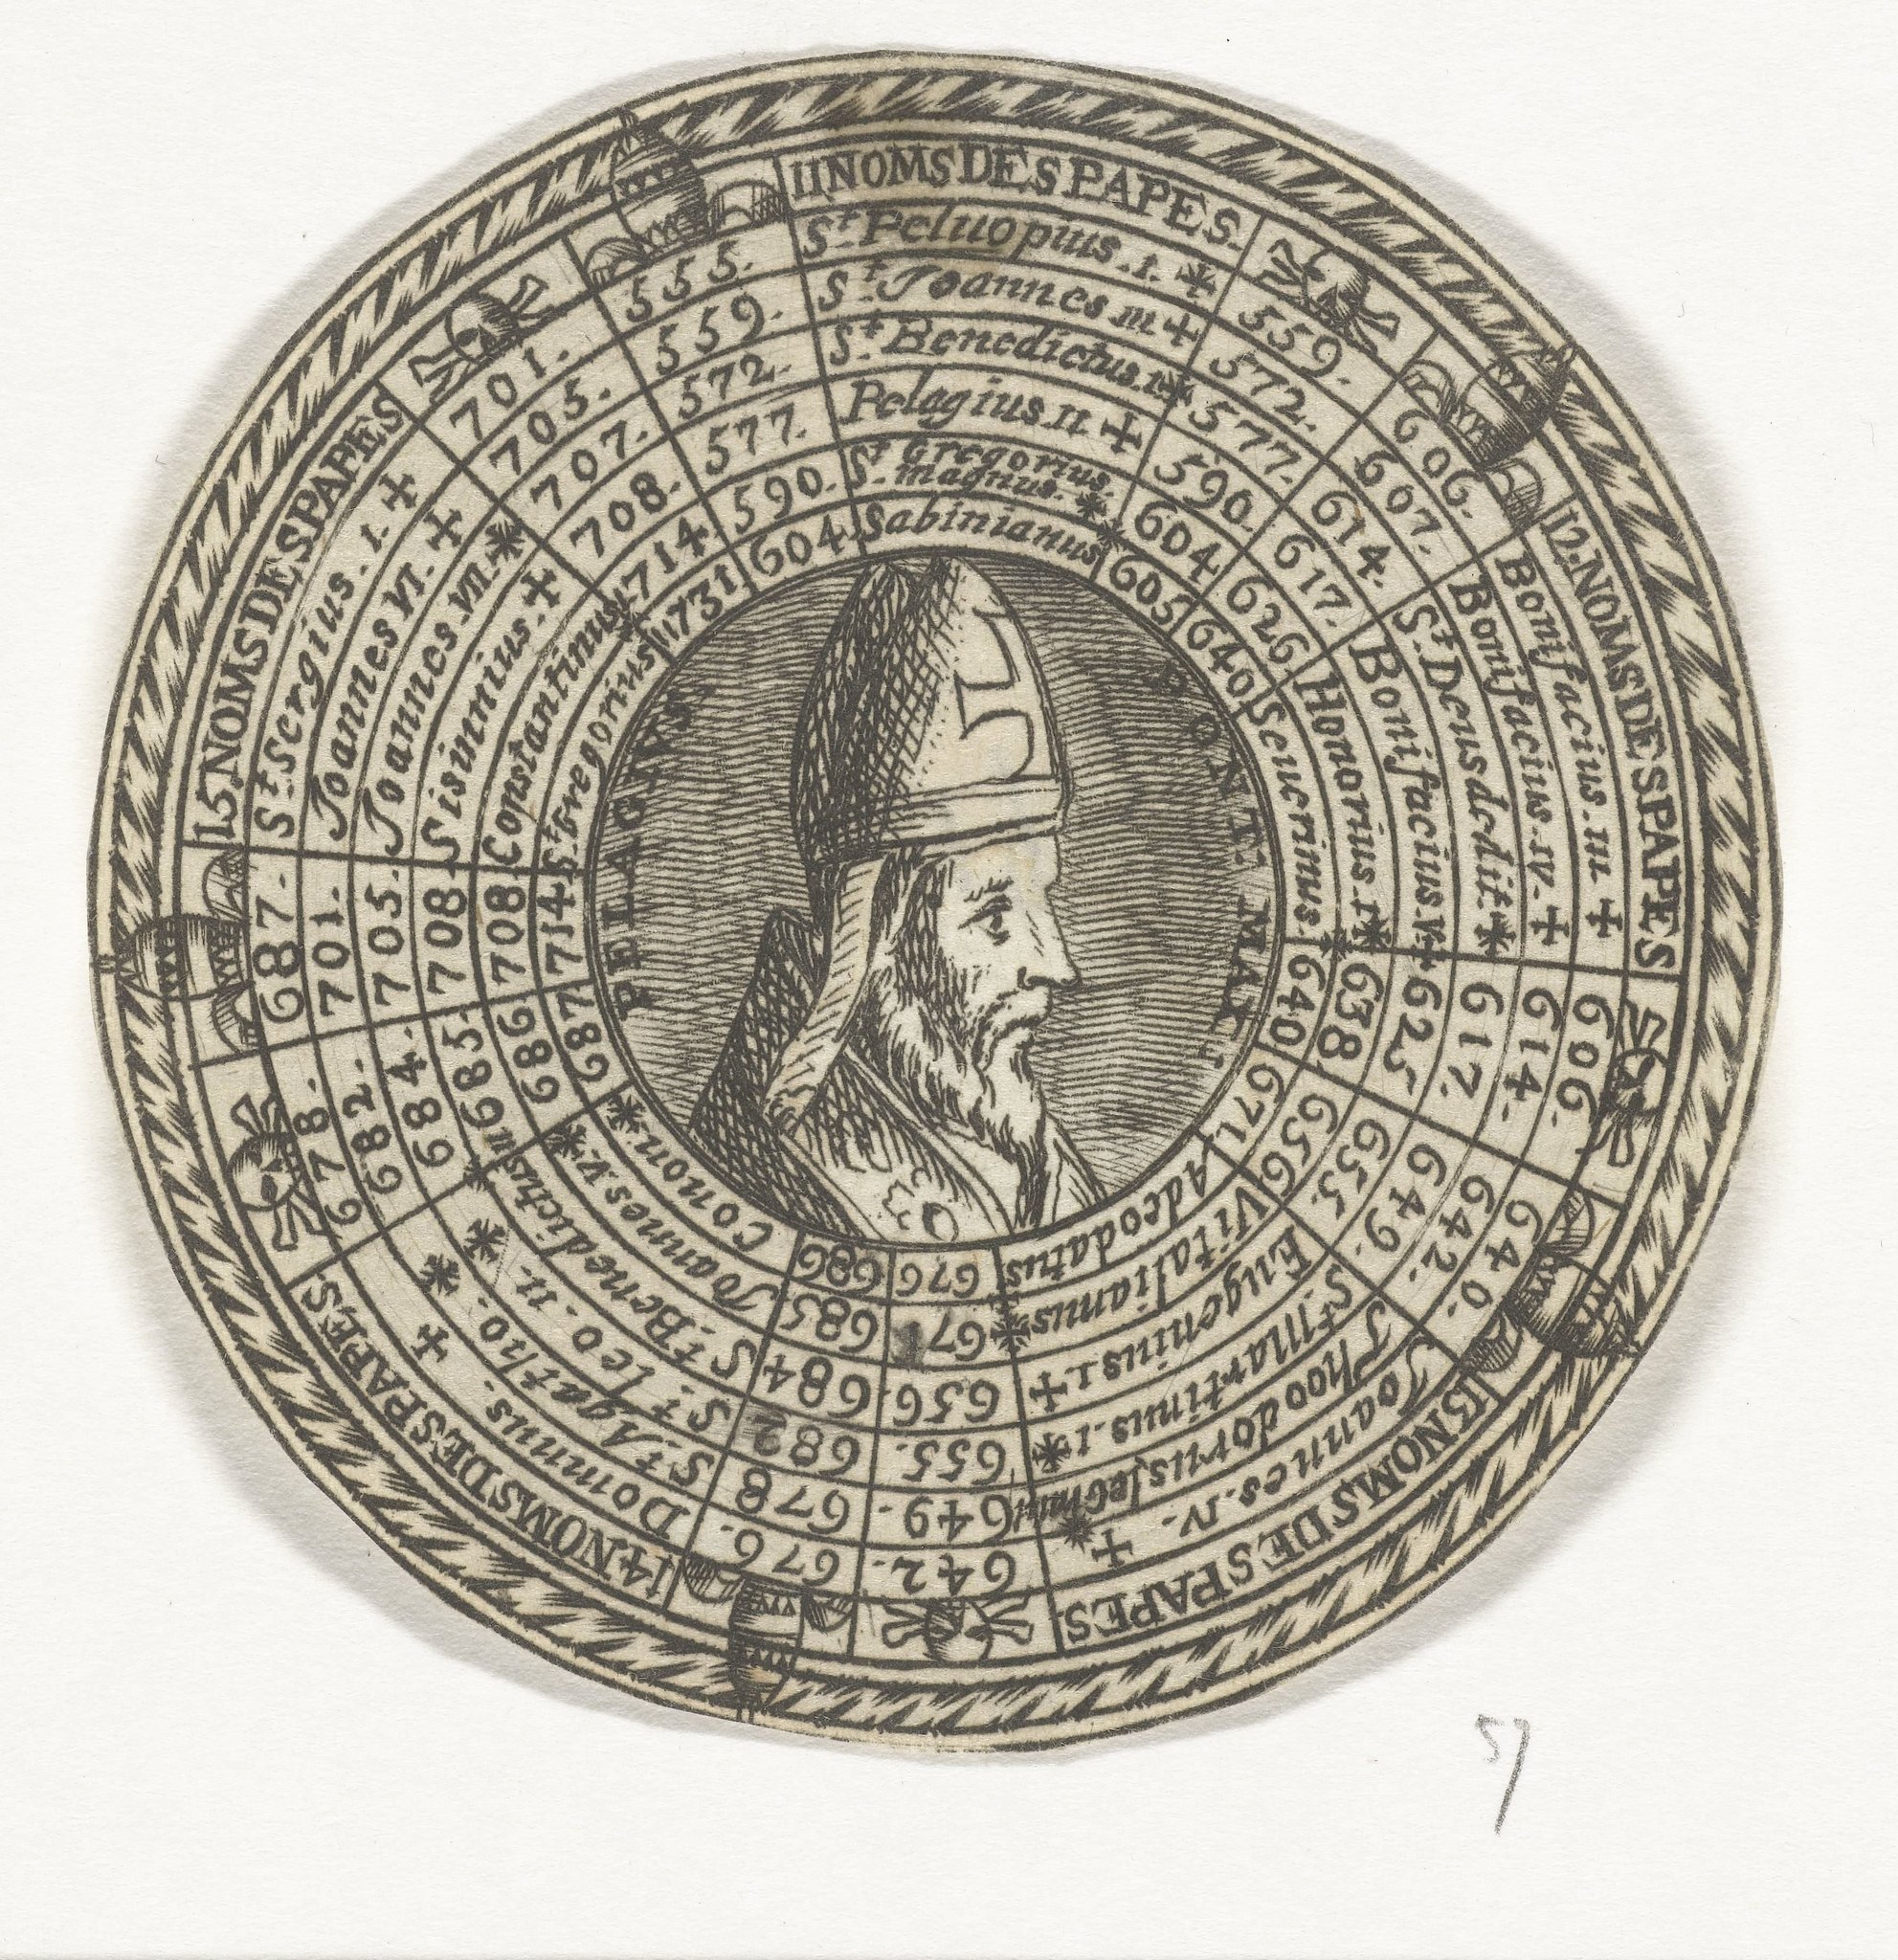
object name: print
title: Penning met het portret van Pelagius I en de namen van de pausen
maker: Anonymous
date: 1685-1720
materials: paper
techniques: etching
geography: amsterdam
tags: rome, pope, seal (symbol of sovereignty)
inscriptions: number: ‘61’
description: Ontwerp van een ronde penning met, in zeven concentrische cirkels, de namen van de pausen en hun regeringsjaren, beginnende bij Pelagius I en eindigend bij paus Gregorius II. In het midden van de penning het portret van paus Pelagius I.